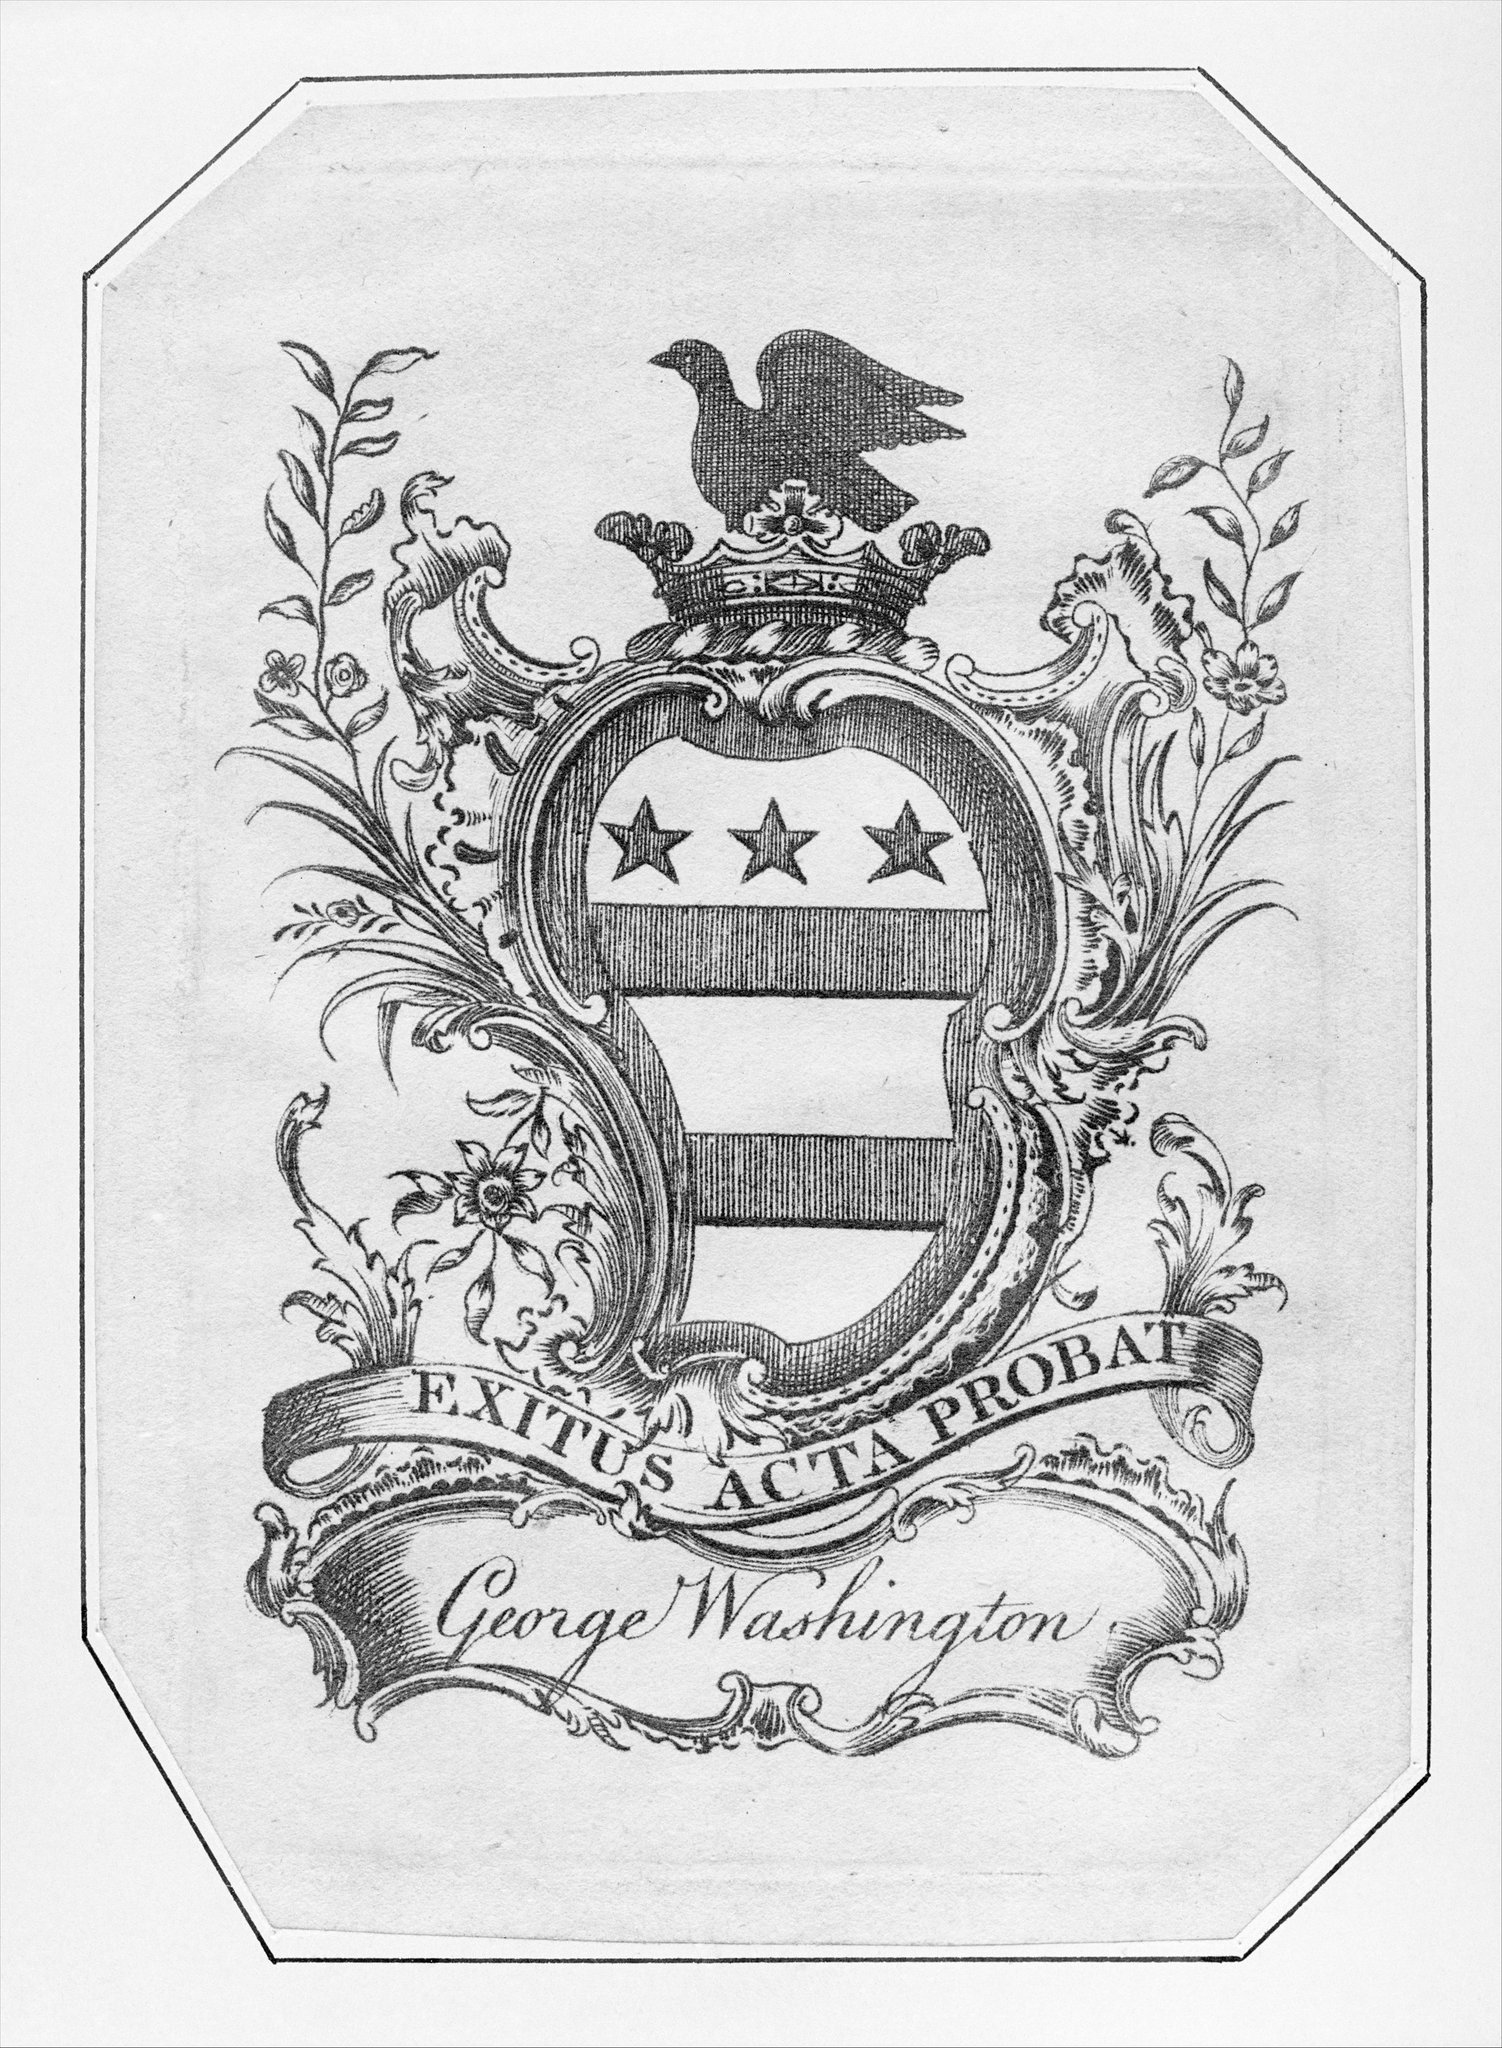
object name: print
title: Bookplate of George Washington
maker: anonymous, british, 18th century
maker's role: artist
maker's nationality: british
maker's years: 1700-1800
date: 1772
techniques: engraving, etching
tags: birds,coat of arms